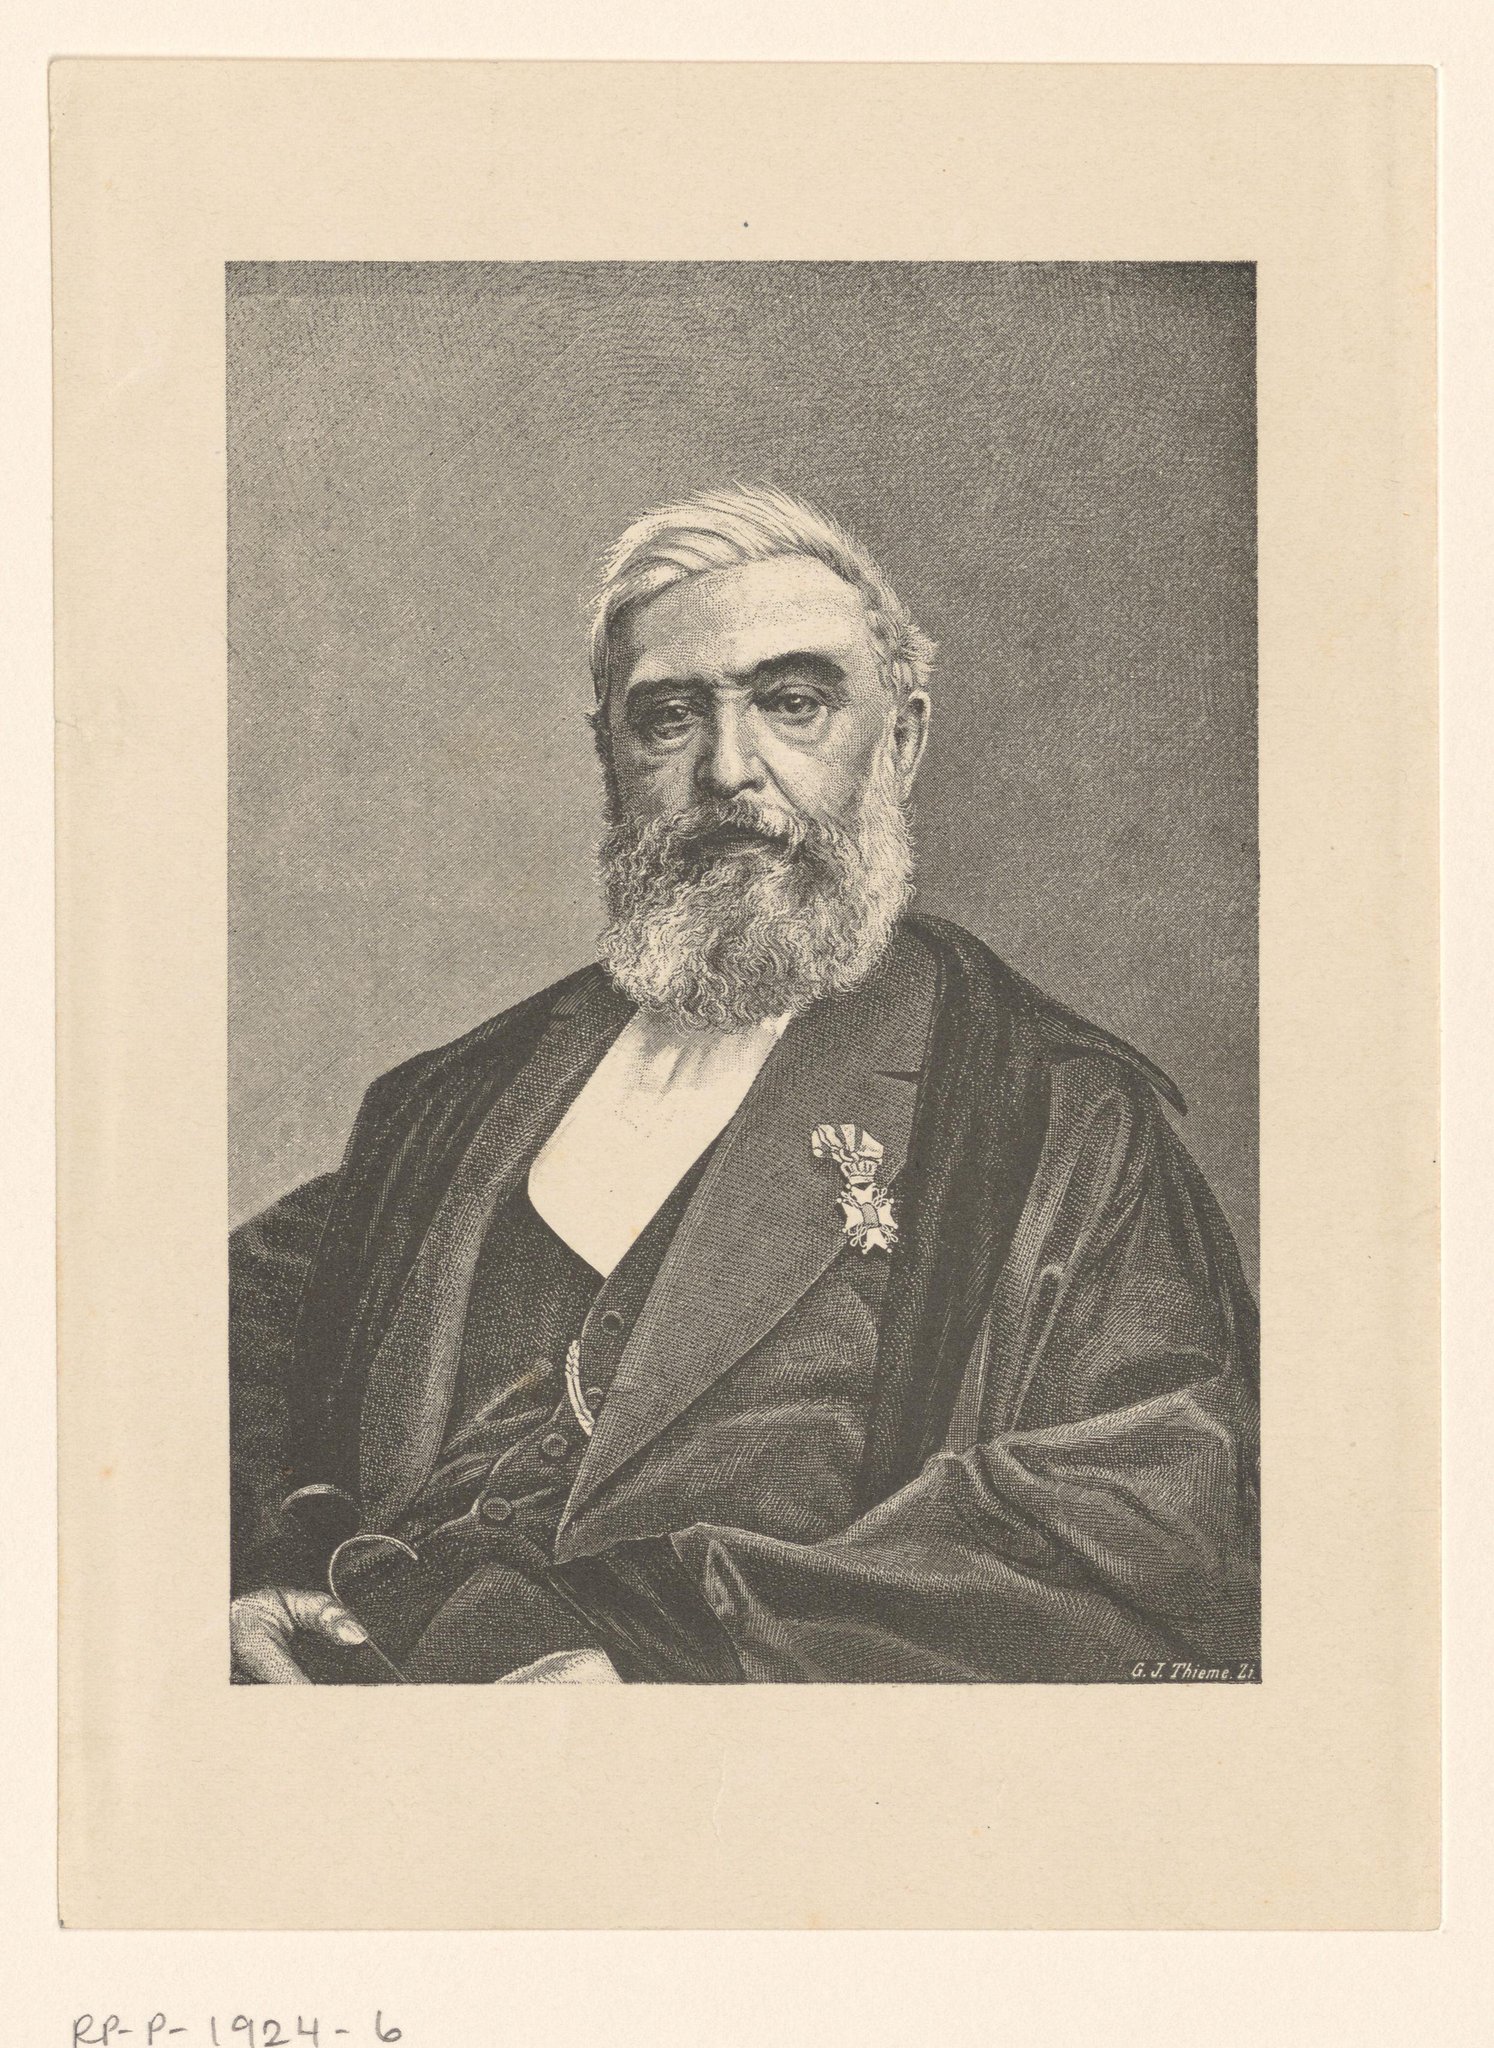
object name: photomechanical print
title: Portret van Abraham Everardus Simon Thomas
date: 1900-1924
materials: paper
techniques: autotype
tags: historical persons, professor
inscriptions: collector's mark: Lugt 2233